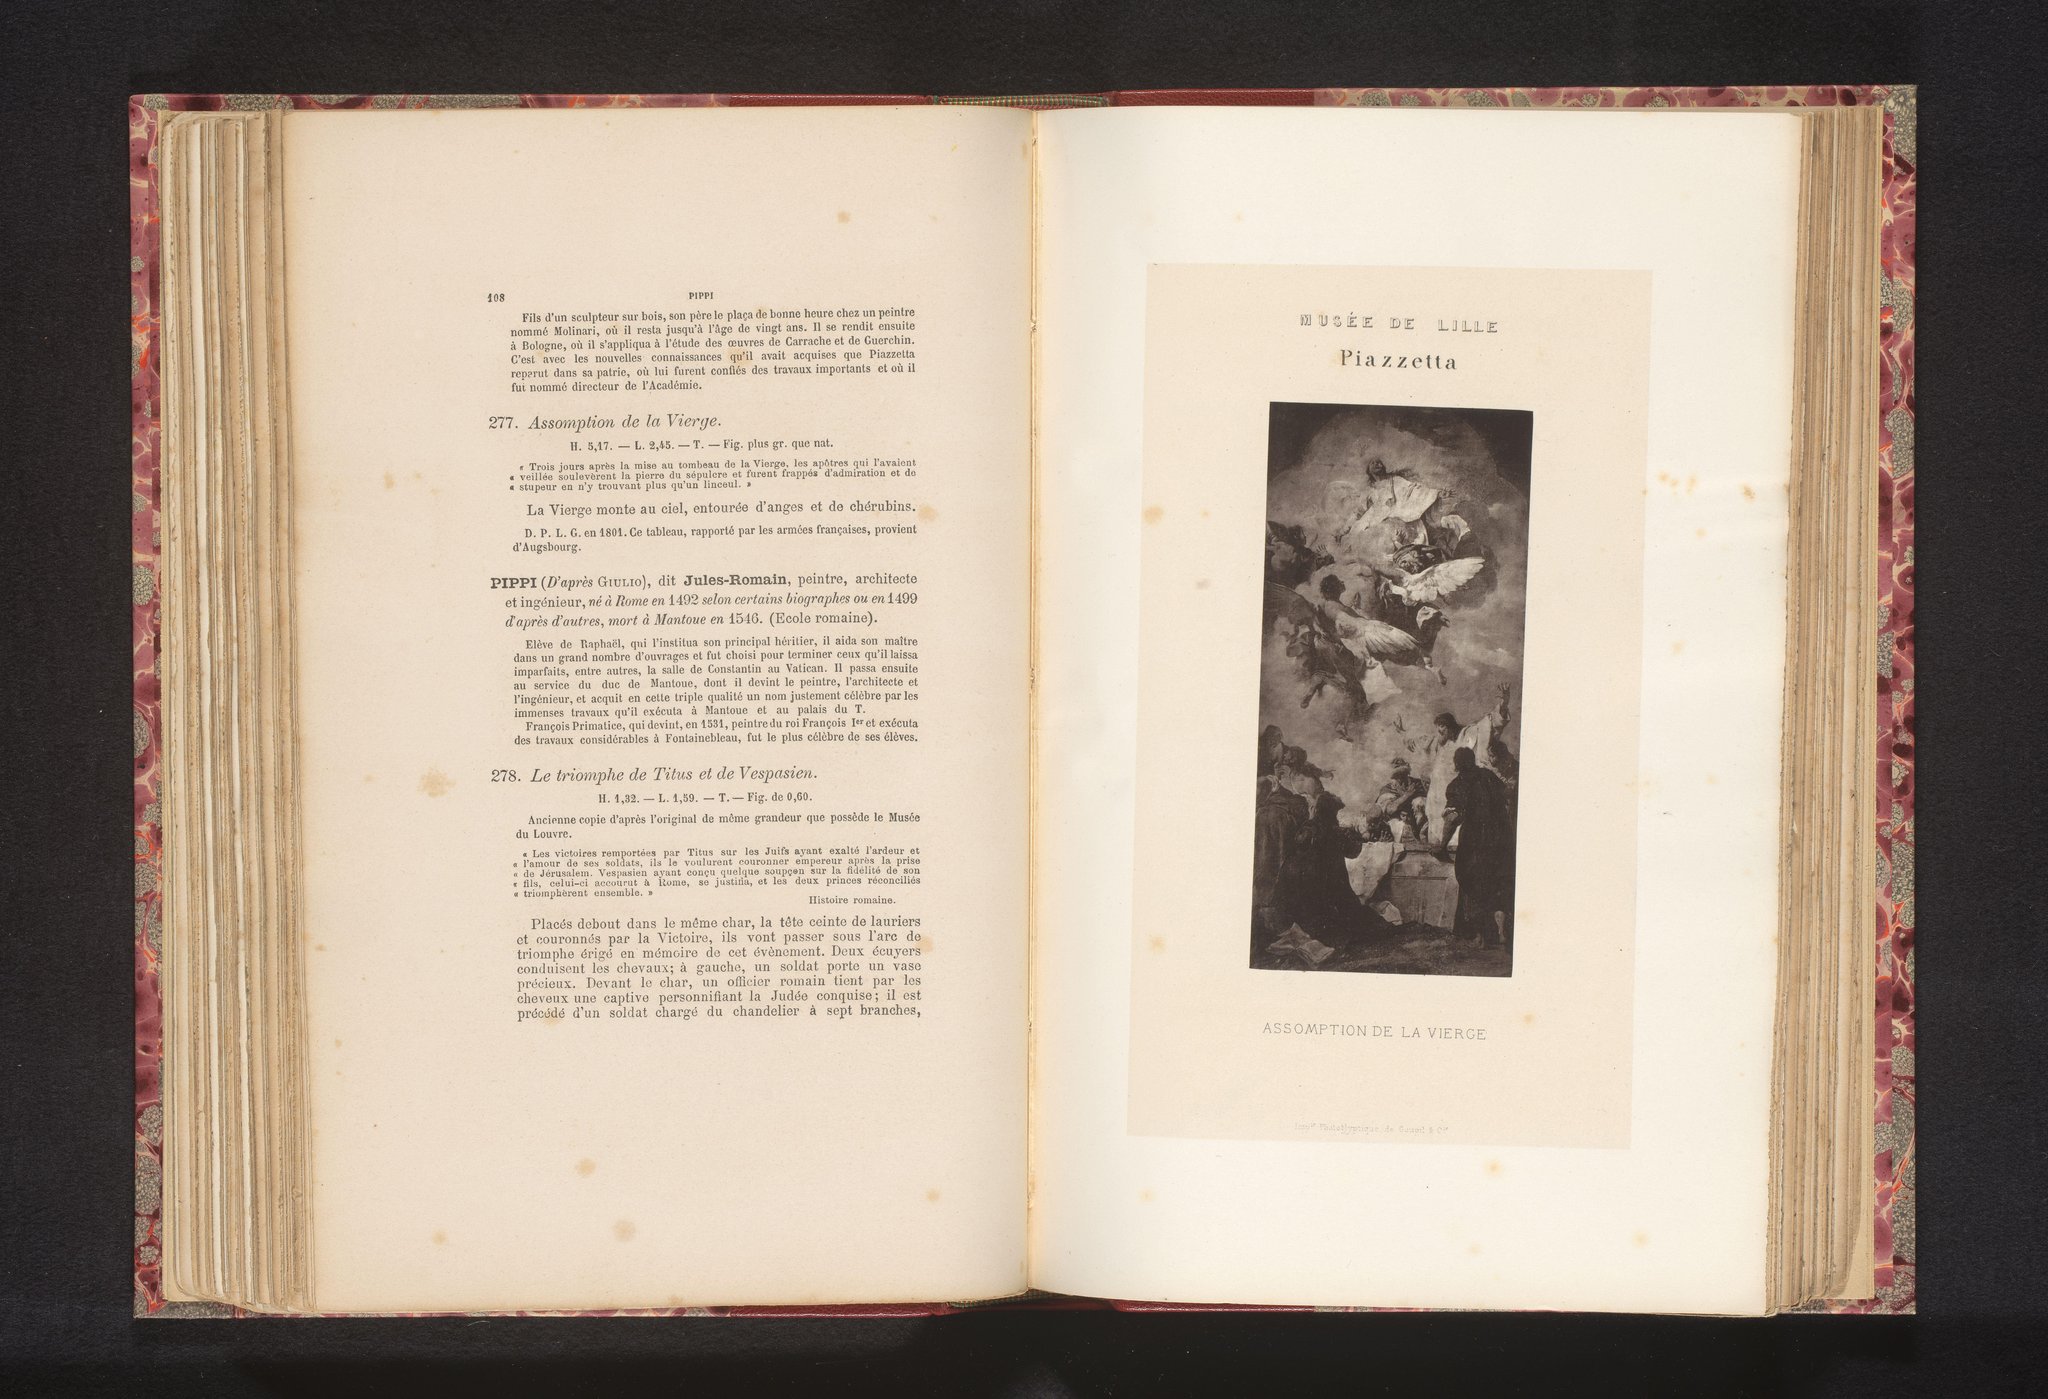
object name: page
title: Fotoreproductie van een schilderij door Giovanni Battista Piazzetta, voorstellend de Hemelvaart van Maria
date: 1862-1872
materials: paper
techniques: woodburytype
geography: lille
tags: the assumption of mary ('assumptio corporis'): she is borne into heaven by angels